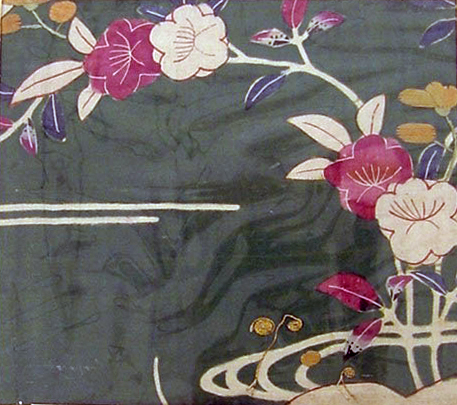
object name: piece from a kosode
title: Piece from a Kosode with Orange Blossoms and Stream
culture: japanese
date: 1615-1868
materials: metal thread, silk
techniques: dyeing, embroidery, painting, weave, resist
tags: flowers